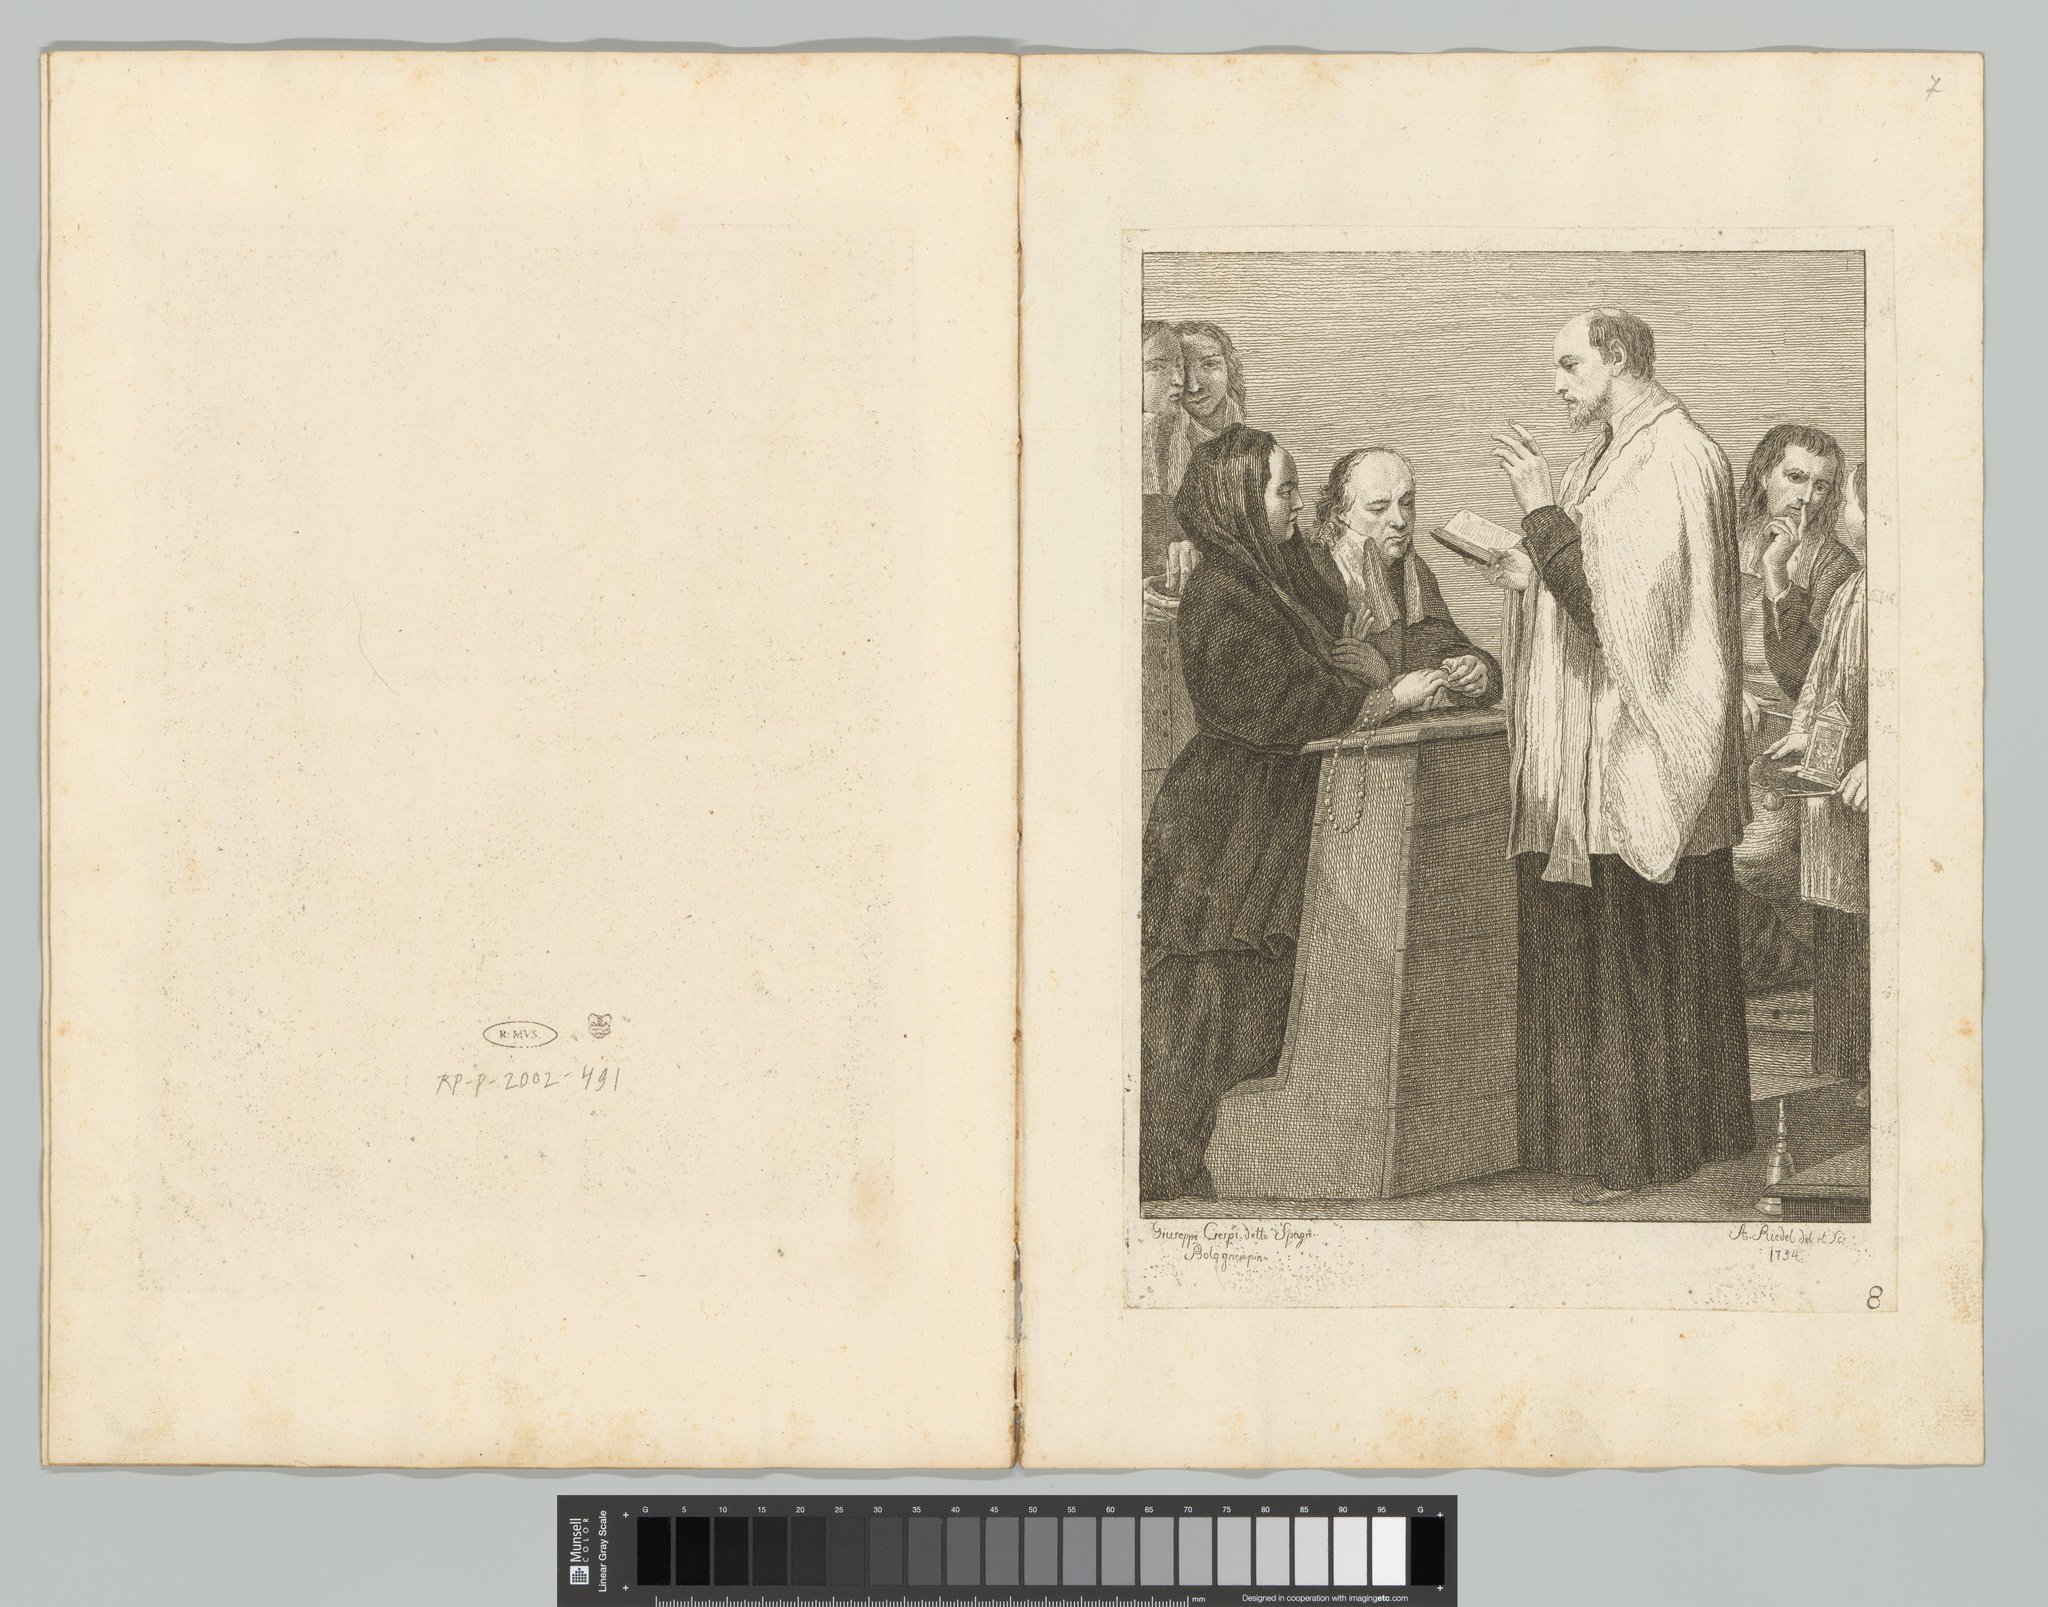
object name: print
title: Zeven sacramenten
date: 1754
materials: paper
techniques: etching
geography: bologna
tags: marriage in church ~ the sixth of the seven sacraments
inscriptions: collector's mark: Lugt 2760, collector's mark: Lugt 2228